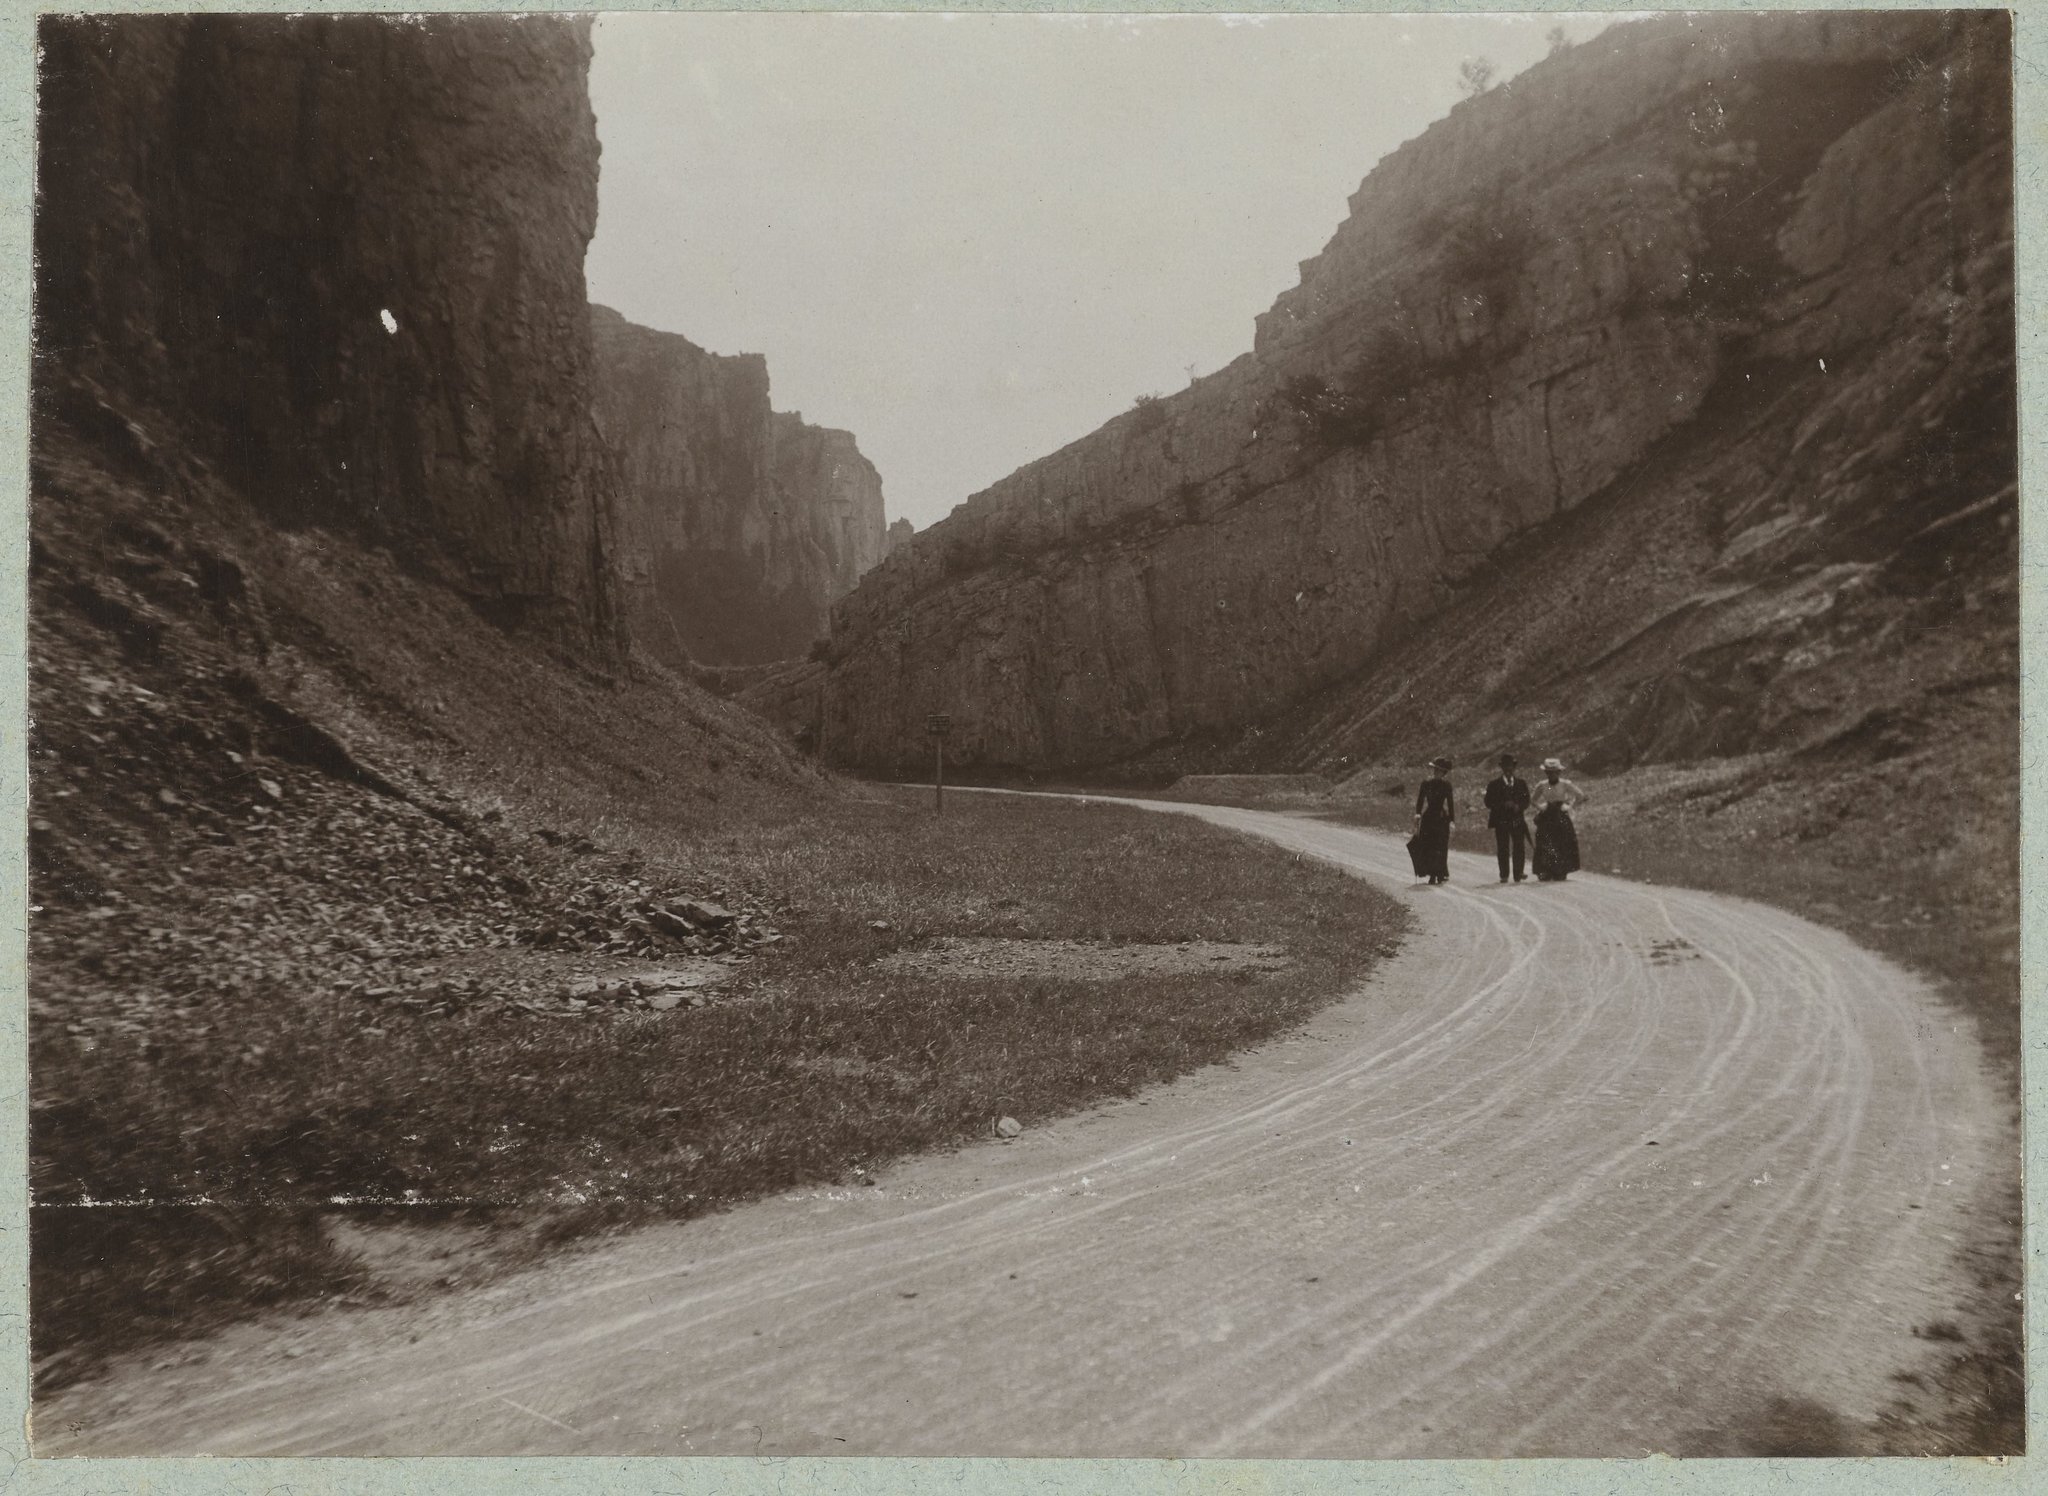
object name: photograph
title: Photographieën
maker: frits freerks fontein fz.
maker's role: fotograaf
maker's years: 1882-1928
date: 1901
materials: cardboard, paper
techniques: gelatin silver print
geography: england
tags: dutch east indies, the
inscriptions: caption: ‘Way near Chedden with rocks’